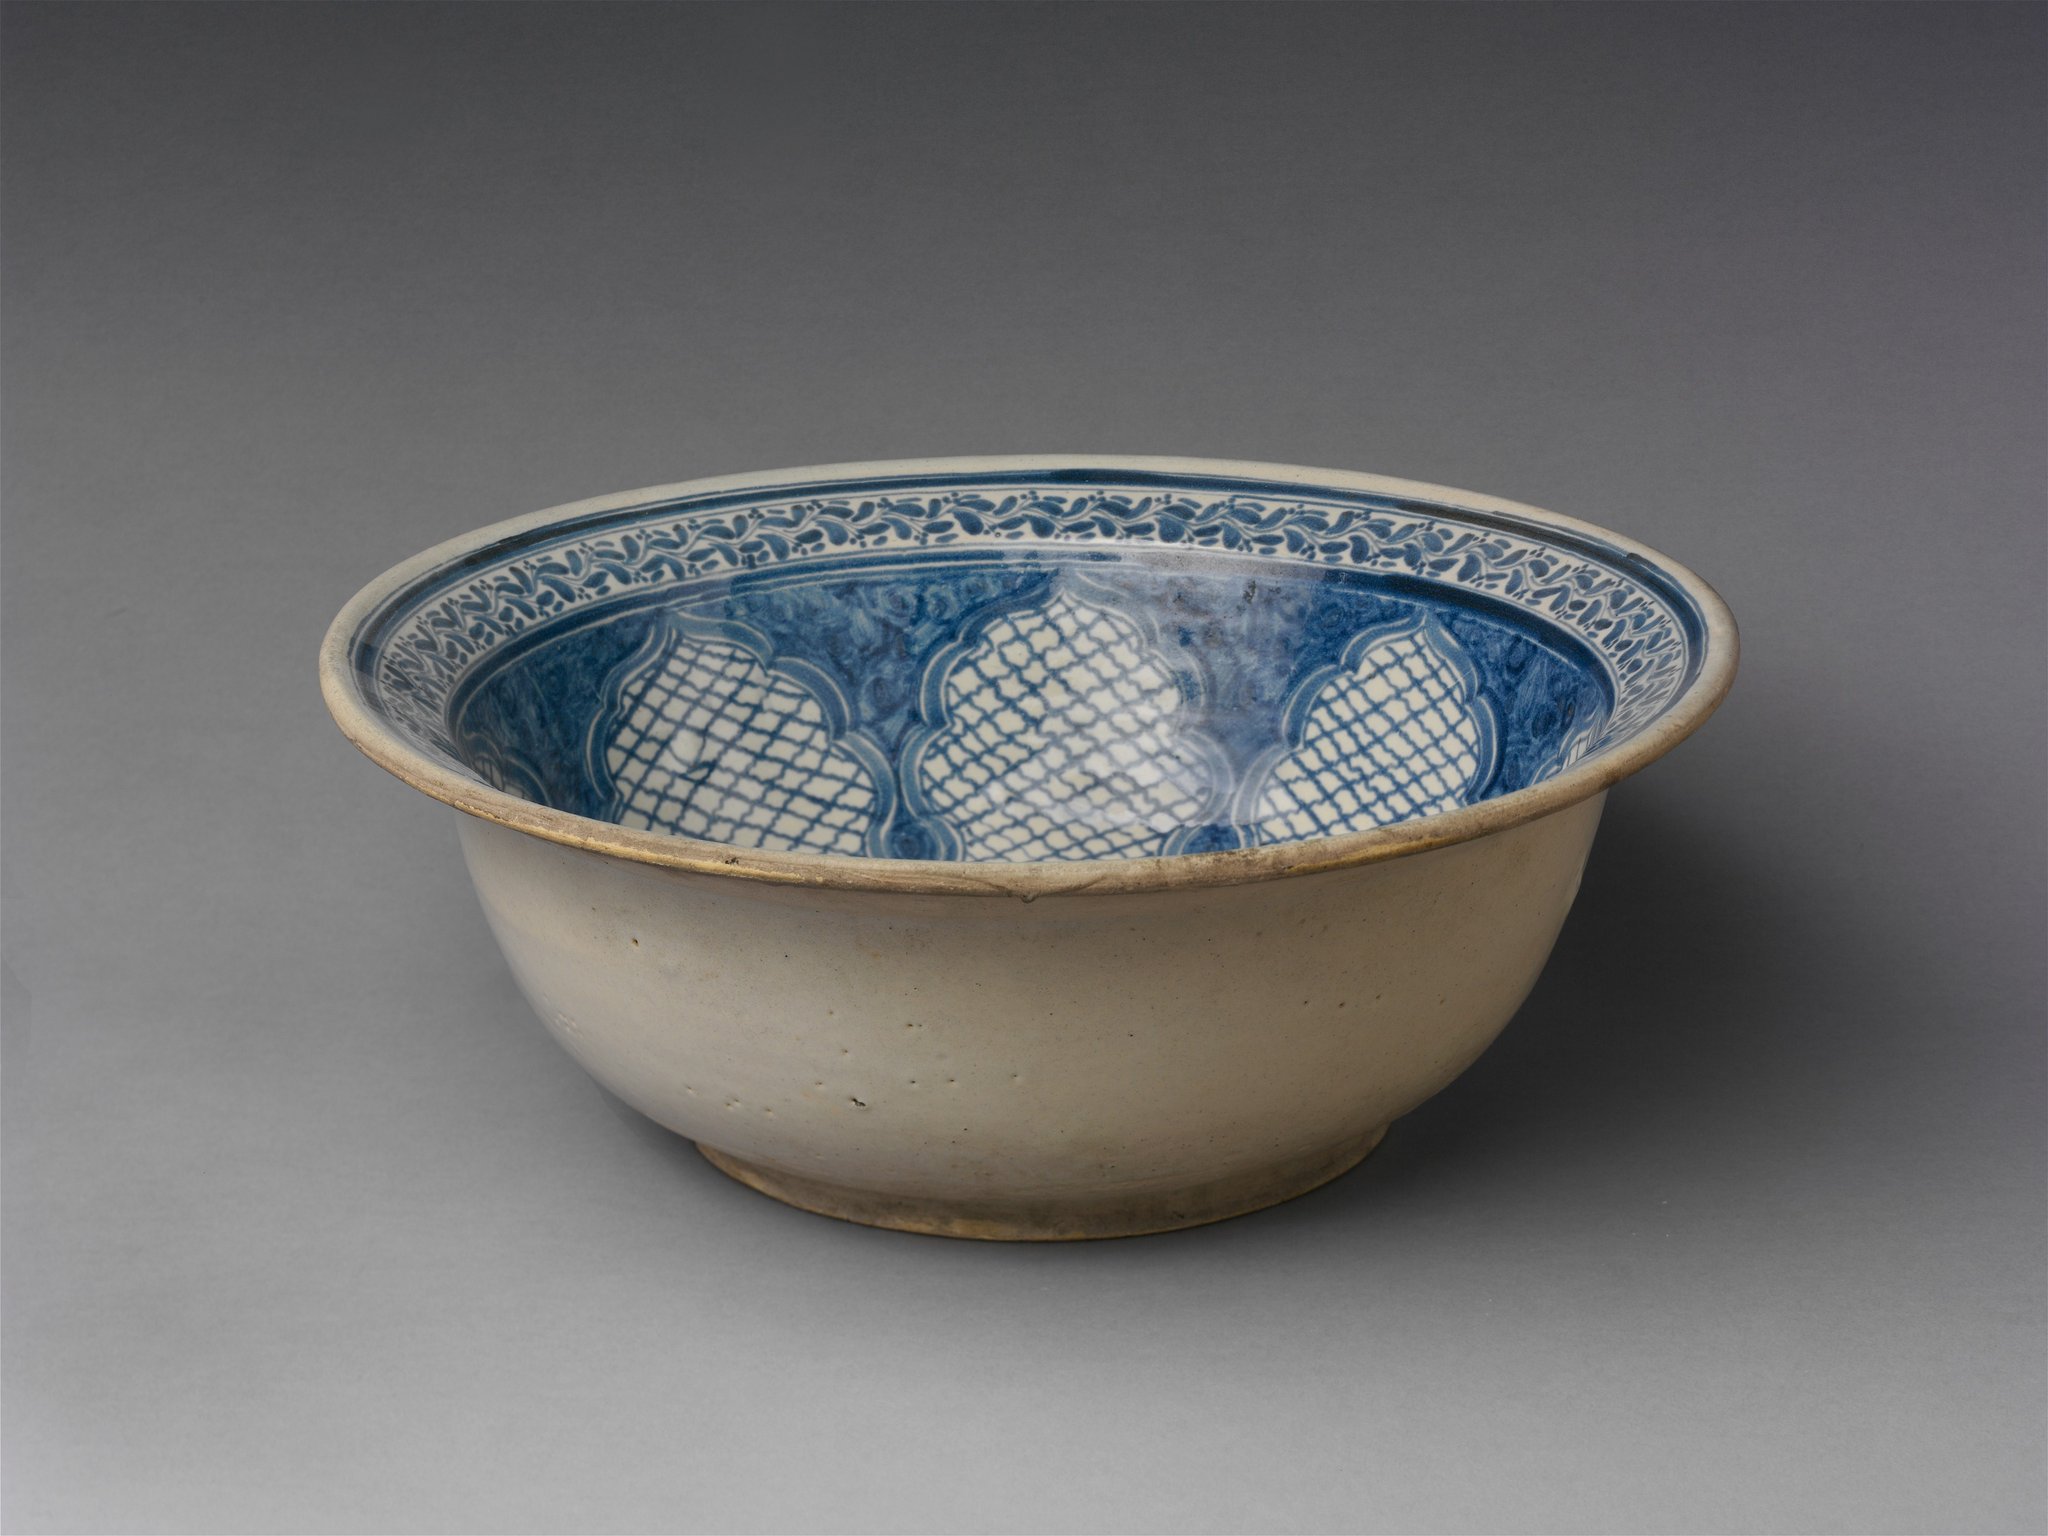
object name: bowl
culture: mexican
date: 1840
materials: earthenware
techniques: glazing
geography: mexico